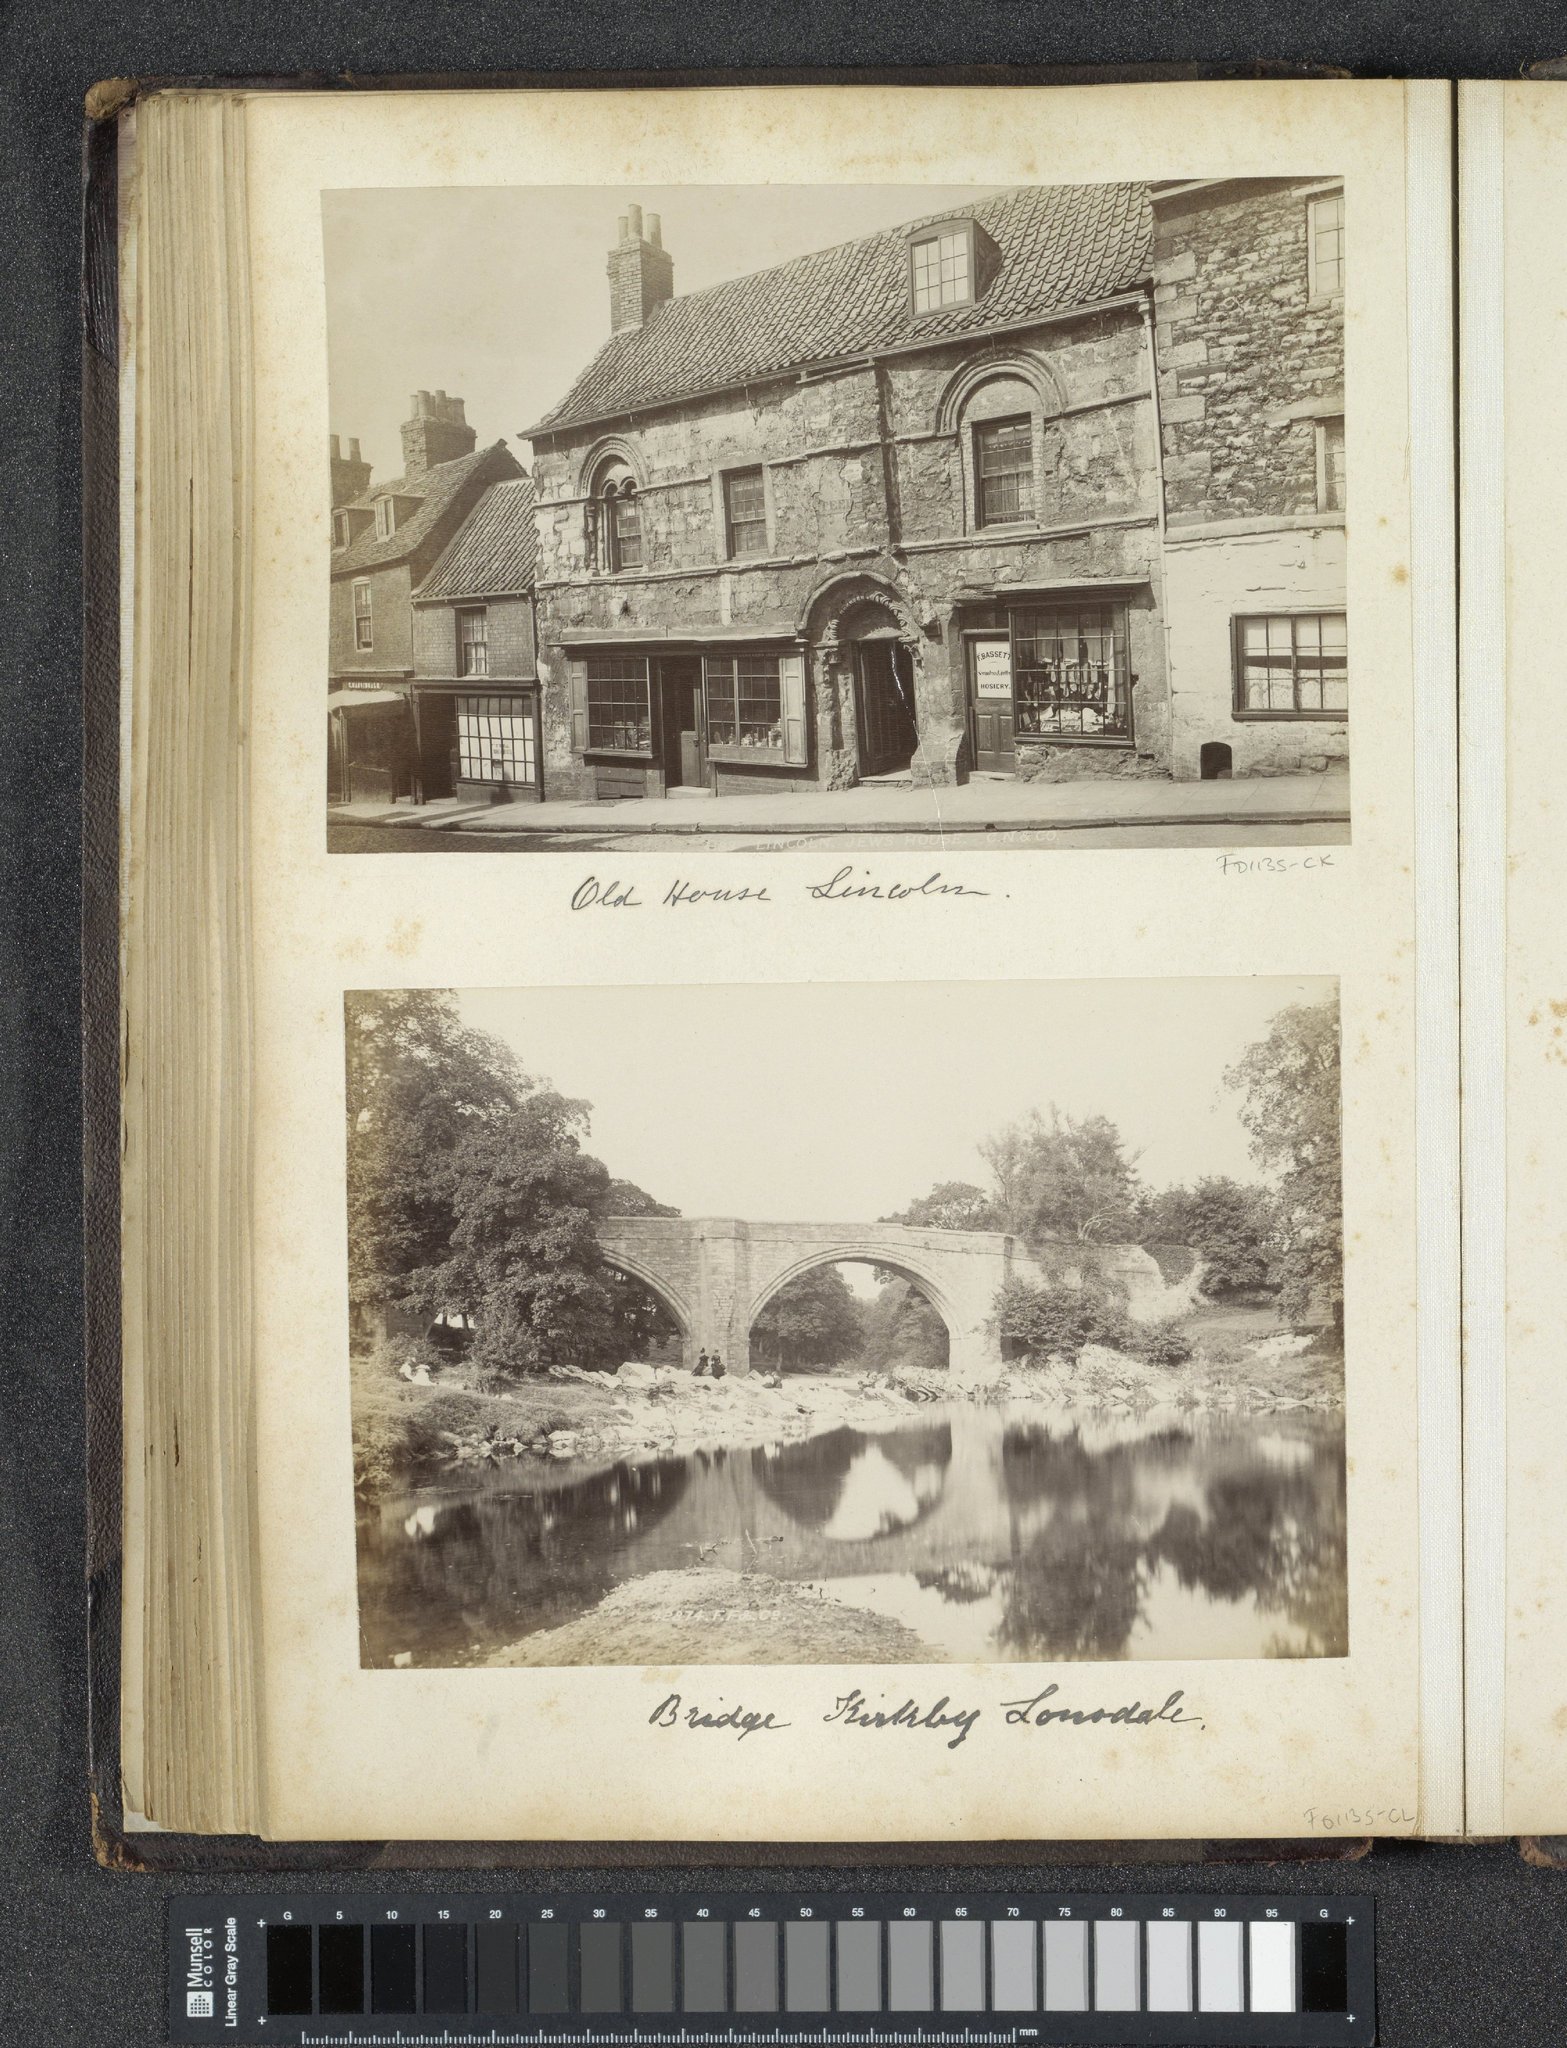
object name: album leaf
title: Gezicht op Devil's Bridge over de Lune in Kirkby Lonsdale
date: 1900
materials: paper, photographic support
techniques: albumen print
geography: kirkby lonsdale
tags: landscape with bridge, viaduct or aqueduct, river (+ landscape with figures, staffage)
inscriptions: negative number: ‘42874’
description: Onderdeel van Reisalbum met foto's van bezienswaardigheden in Engeland en Frankrijk.